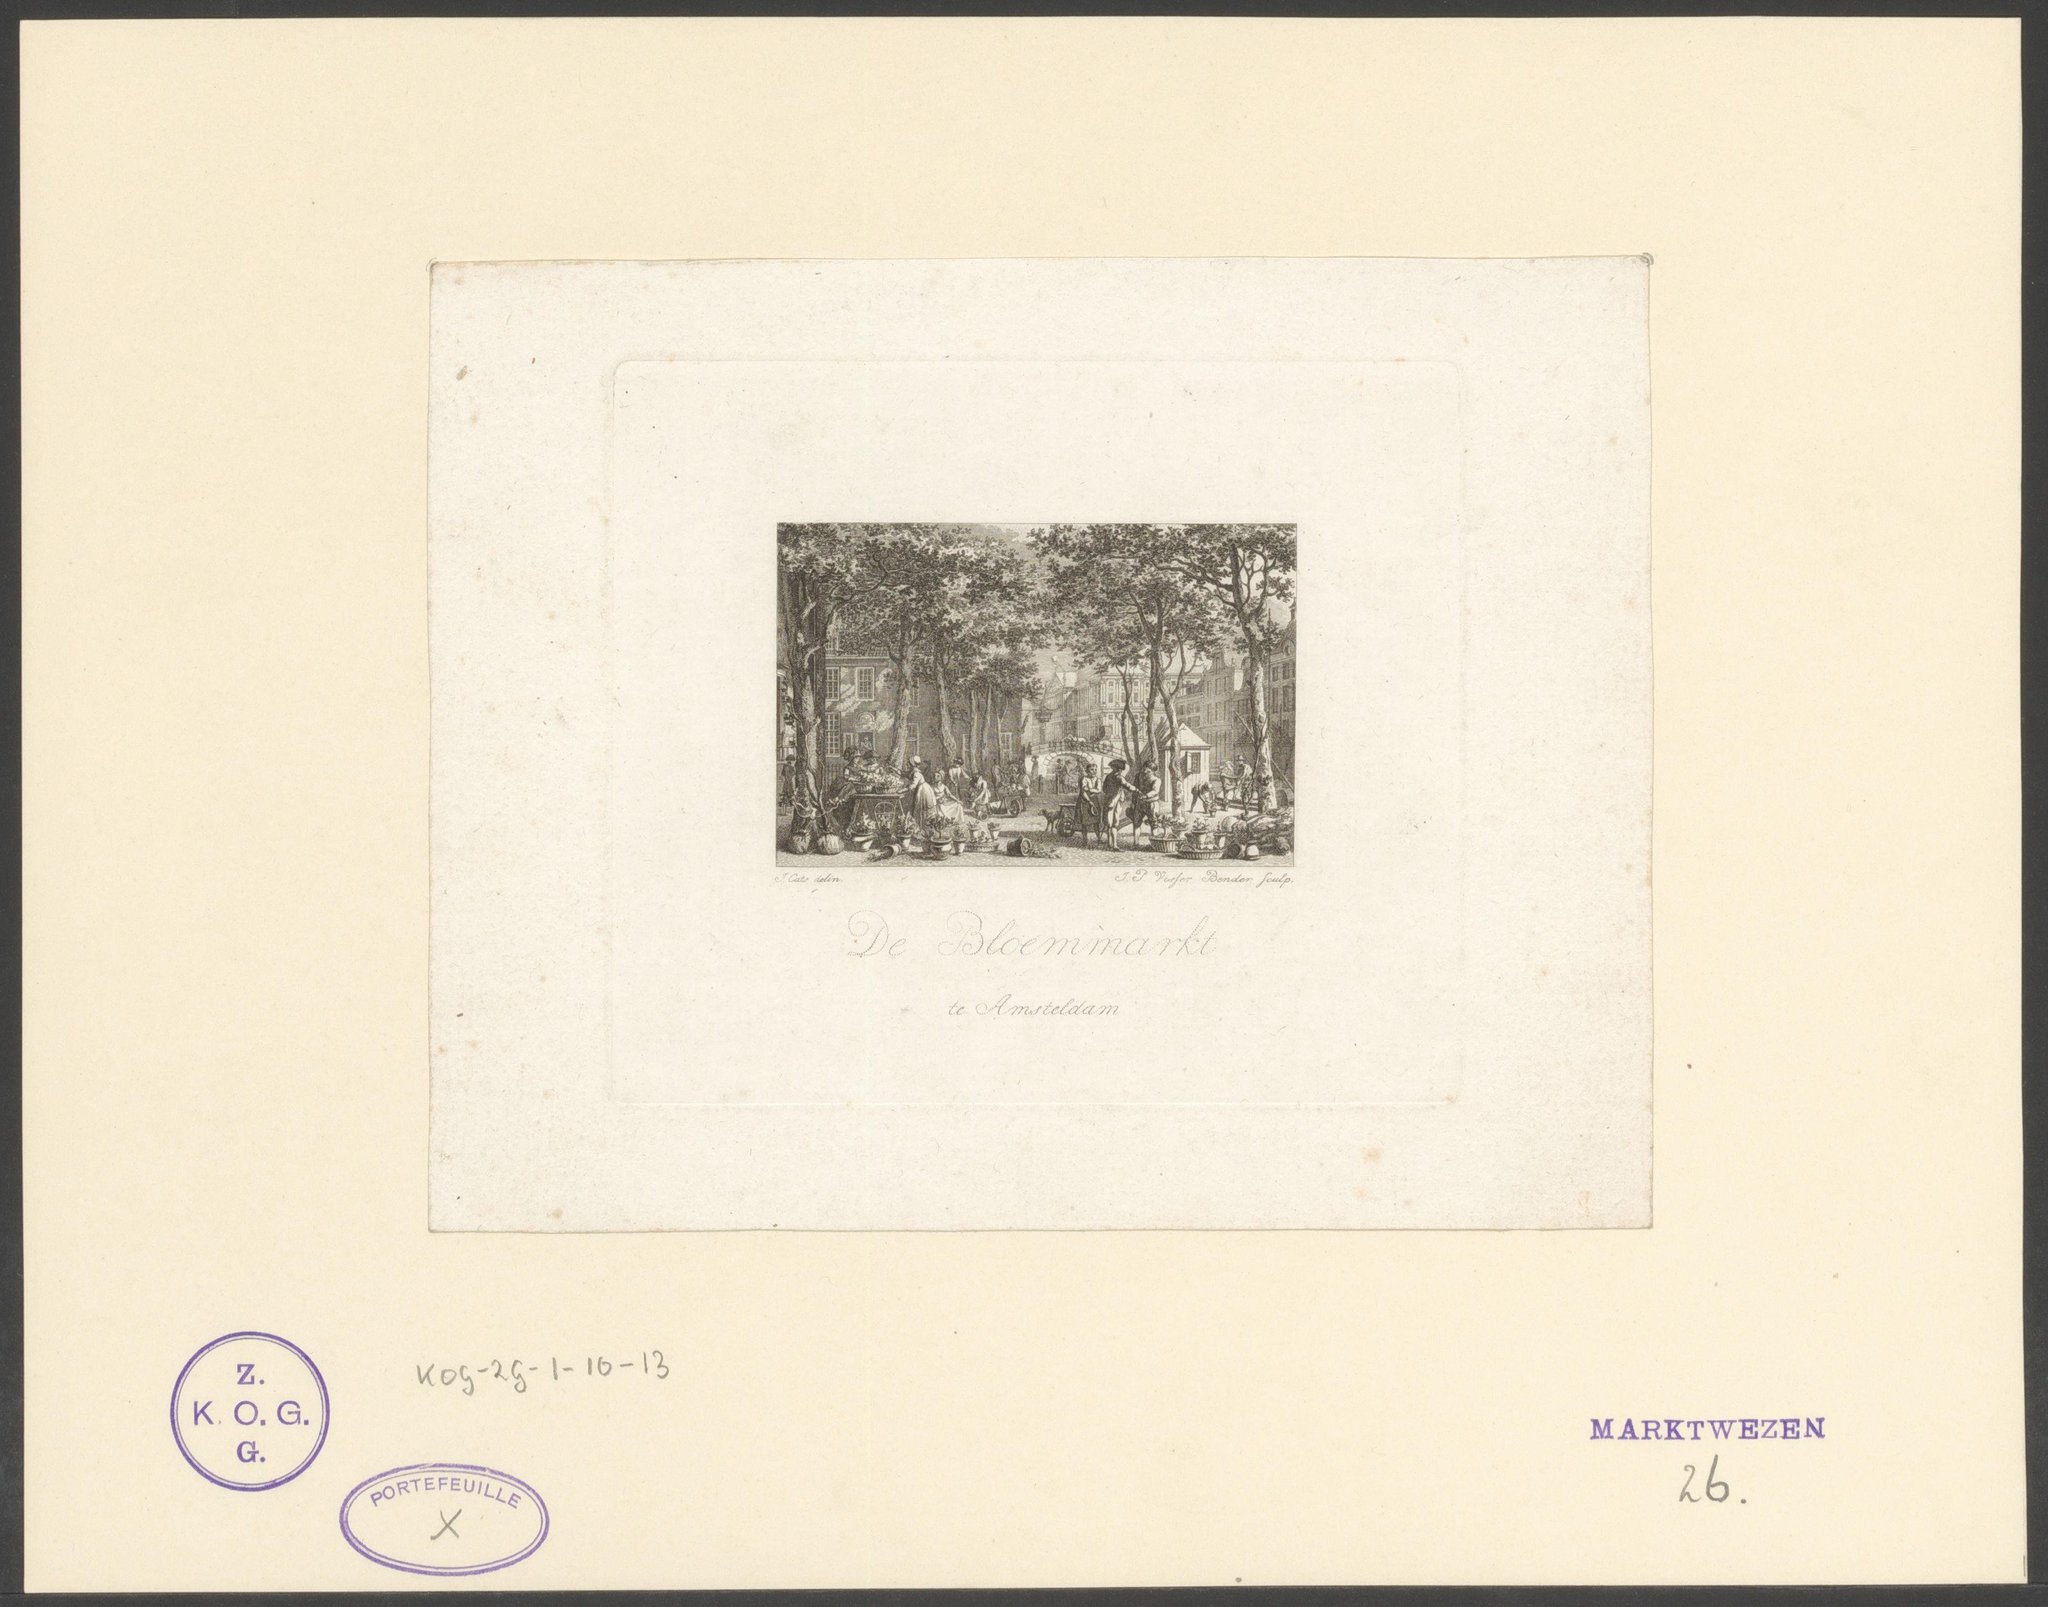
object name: print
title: Gezicht op de Bloemmarkt, Amsterdam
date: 1795-1813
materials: paper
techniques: etching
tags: flowers, plants; vegetation, market, bridge in city across river, canal, etc., royal palace of amsterdam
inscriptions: collector's mark: Lugt 1641, stamp, stamp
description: Gezicht op de Bloemmarkt aan de Nieuwezijds Voorburgwal in noordelijke richting naar de achtergevel van het Koninklijk Paleis. De brug op de achtergrond verbindt de Stilsteeg en de Gasthuisstraat, tegenwoordig allebei onderdeel van de Paleisstraat. Onderwerpsrubrieken binnen de Atlas Zeden en Gewoonten: Handel, nijverheid en verkeer, Marktwezen, Amsterdam.